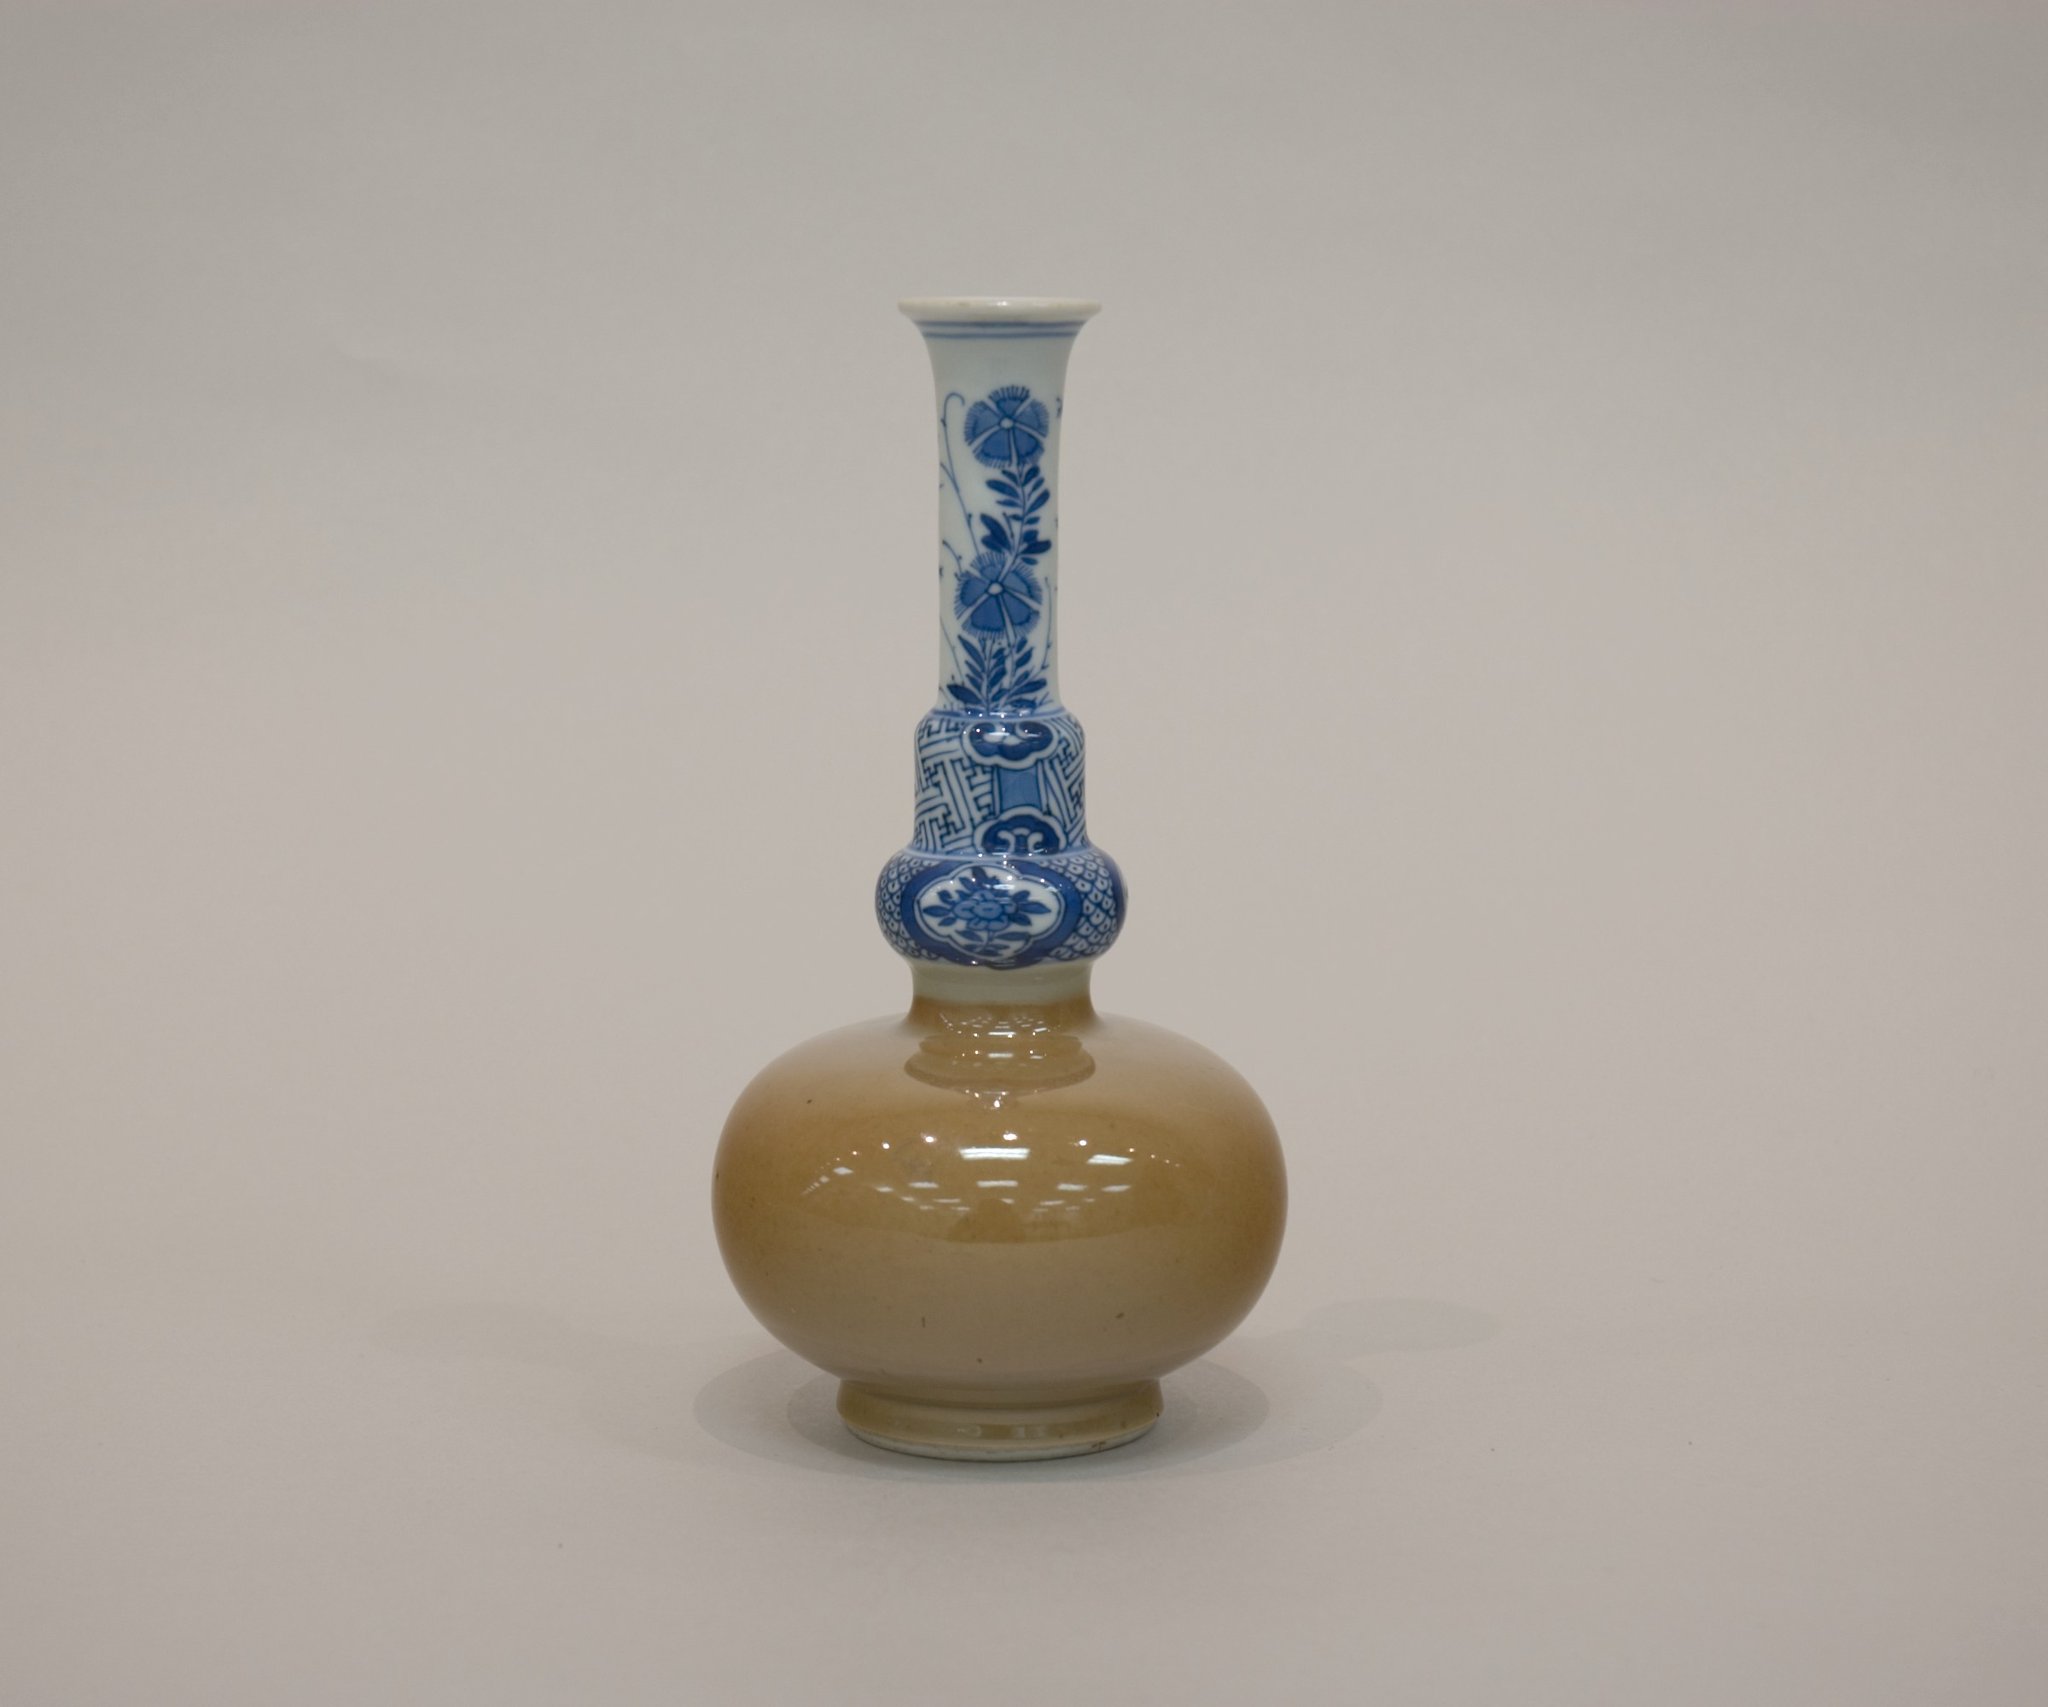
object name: bottle vase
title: Gourd-form bottle vase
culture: chinese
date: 1667-1733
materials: cobalt, glaze, porcelain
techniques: painting, underglaze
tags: flowers